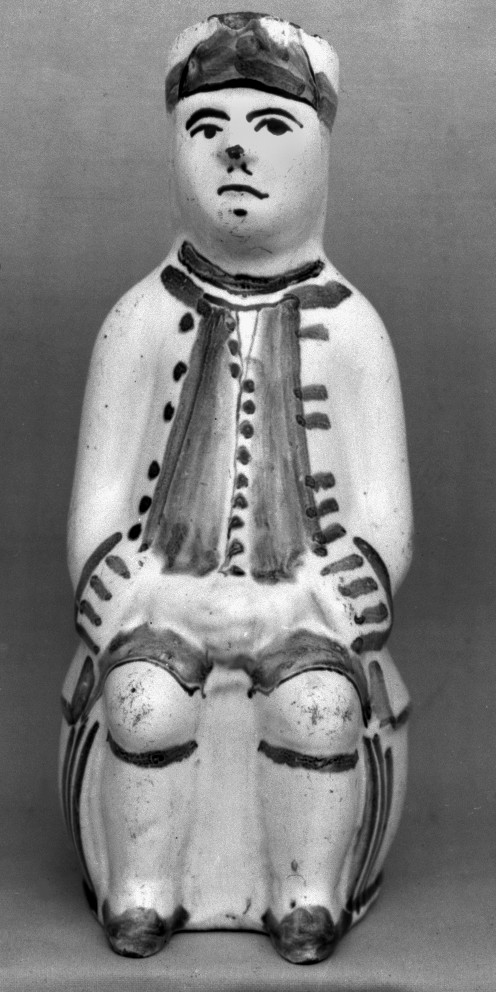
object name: jug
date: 1801-1900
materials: faience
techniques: glazing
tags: men